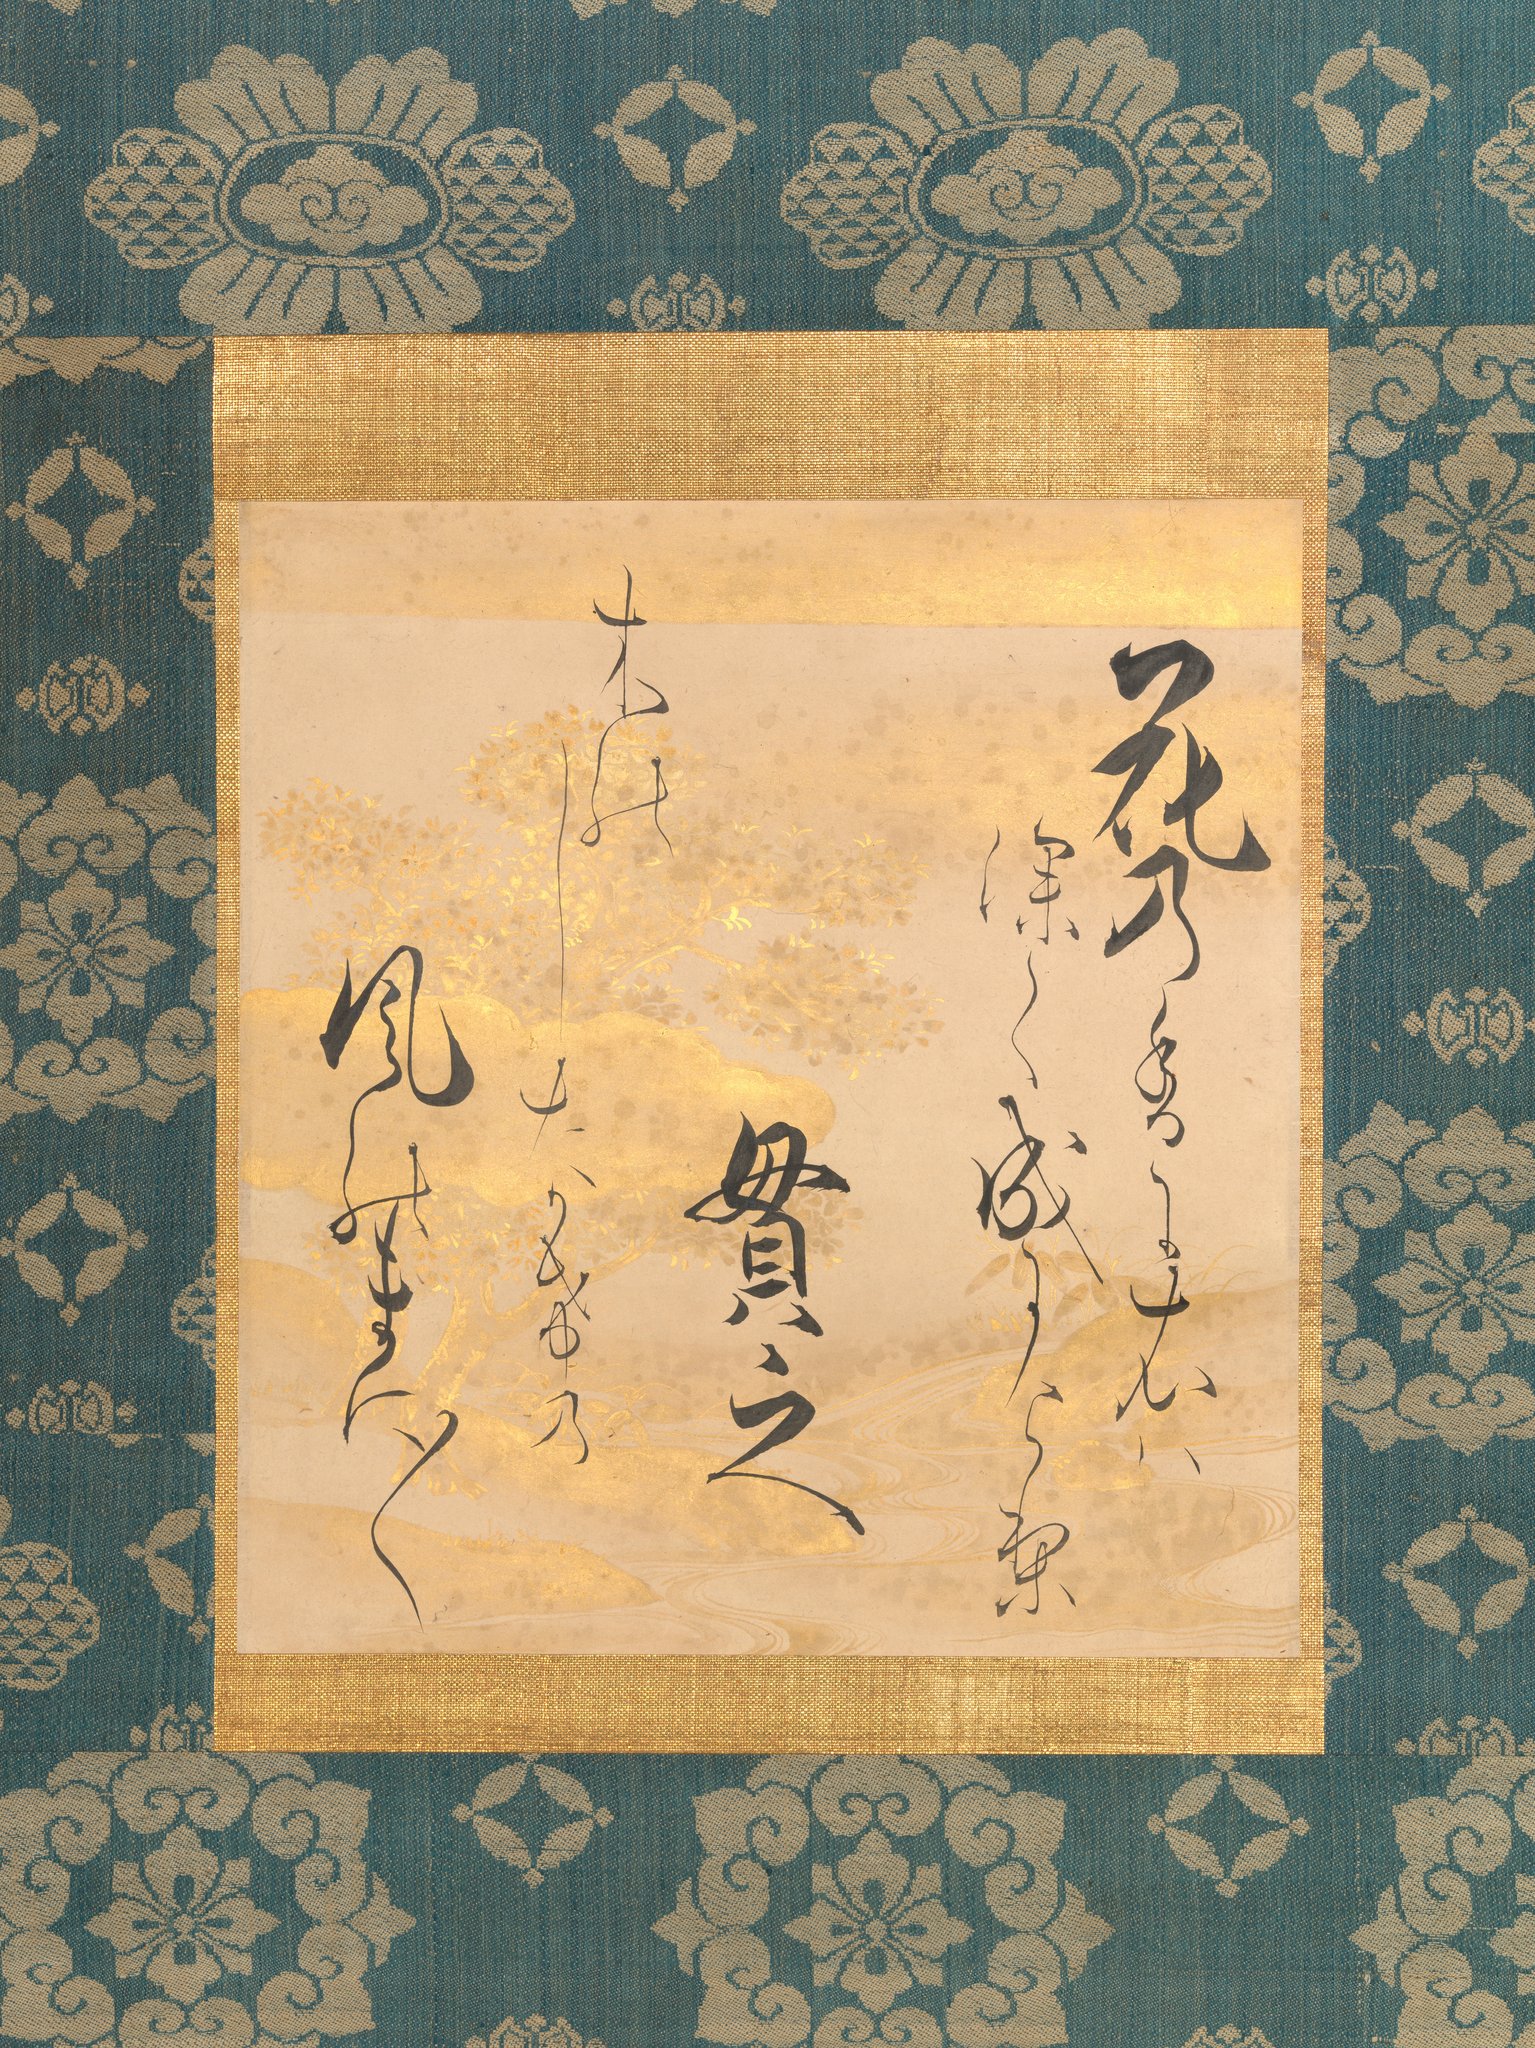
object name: hanging scroll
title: Poem by Ki no Tsurayuki (ca. 872–945) on Decorated Paper with Cherry Blossoms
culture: japanese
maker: ogata sōken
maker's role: artist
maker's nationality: japanese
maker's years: 1621-1687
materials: gold, ink, paper